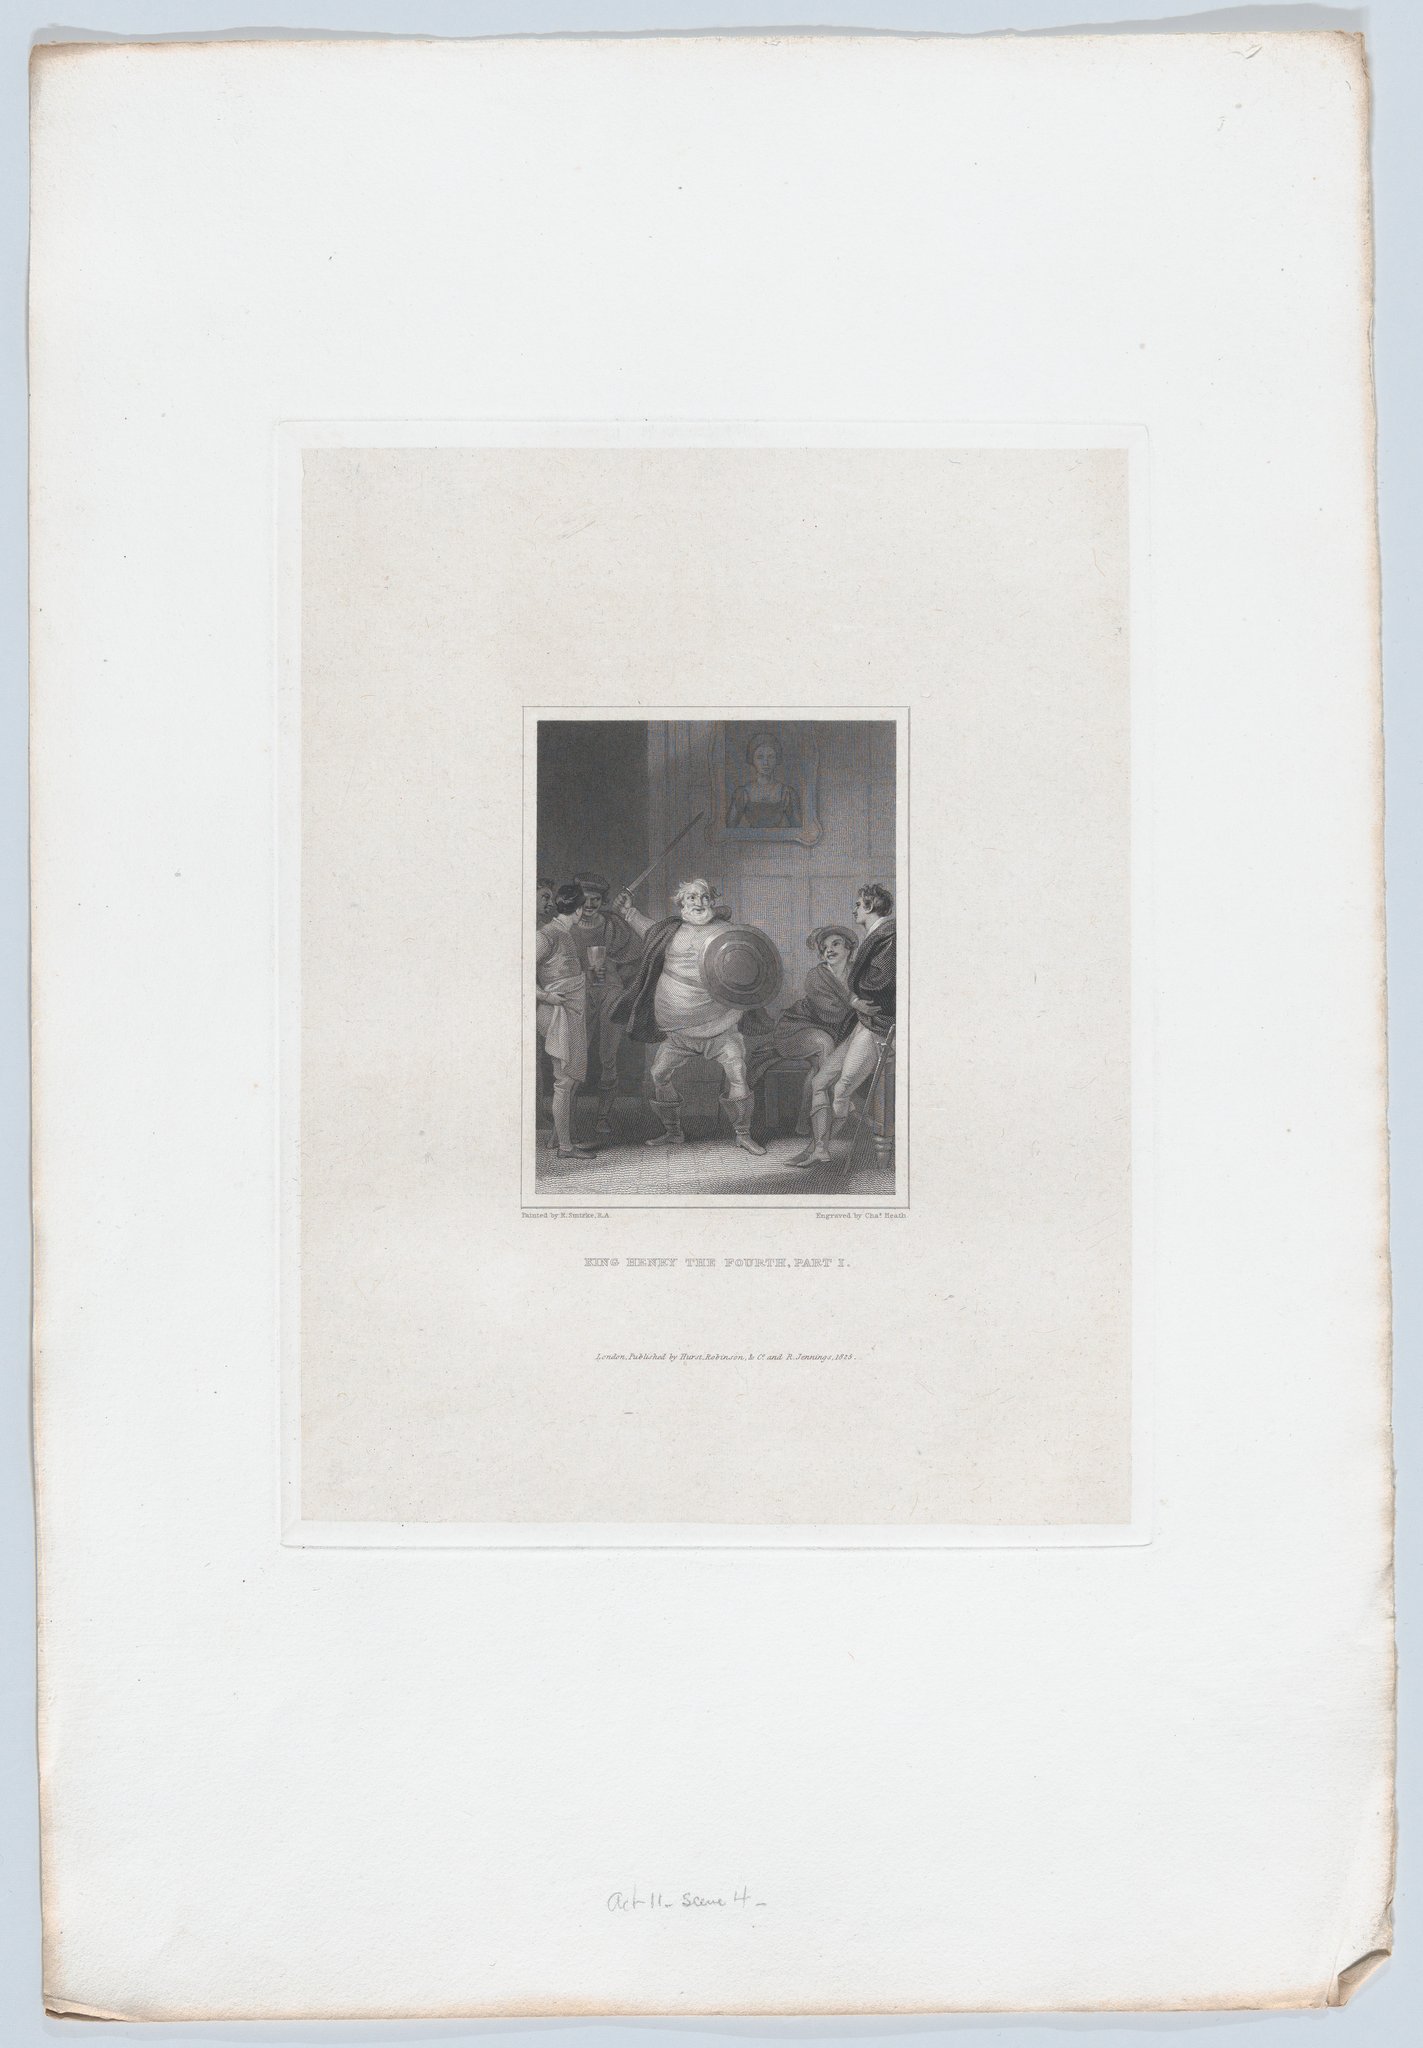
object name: print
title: Prince Henry and Falstaff at the Boar's Head Tavern, Eastcheap (Shakespeare, King Henry the Fourth, Part I, Act 2, Scene 4)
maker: charles heath, the elder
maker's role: engraver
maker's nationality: british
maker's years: 1785-1848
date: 1825-1826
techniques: printmaking, engraving, etching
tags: swords,princes,shakespeare,men